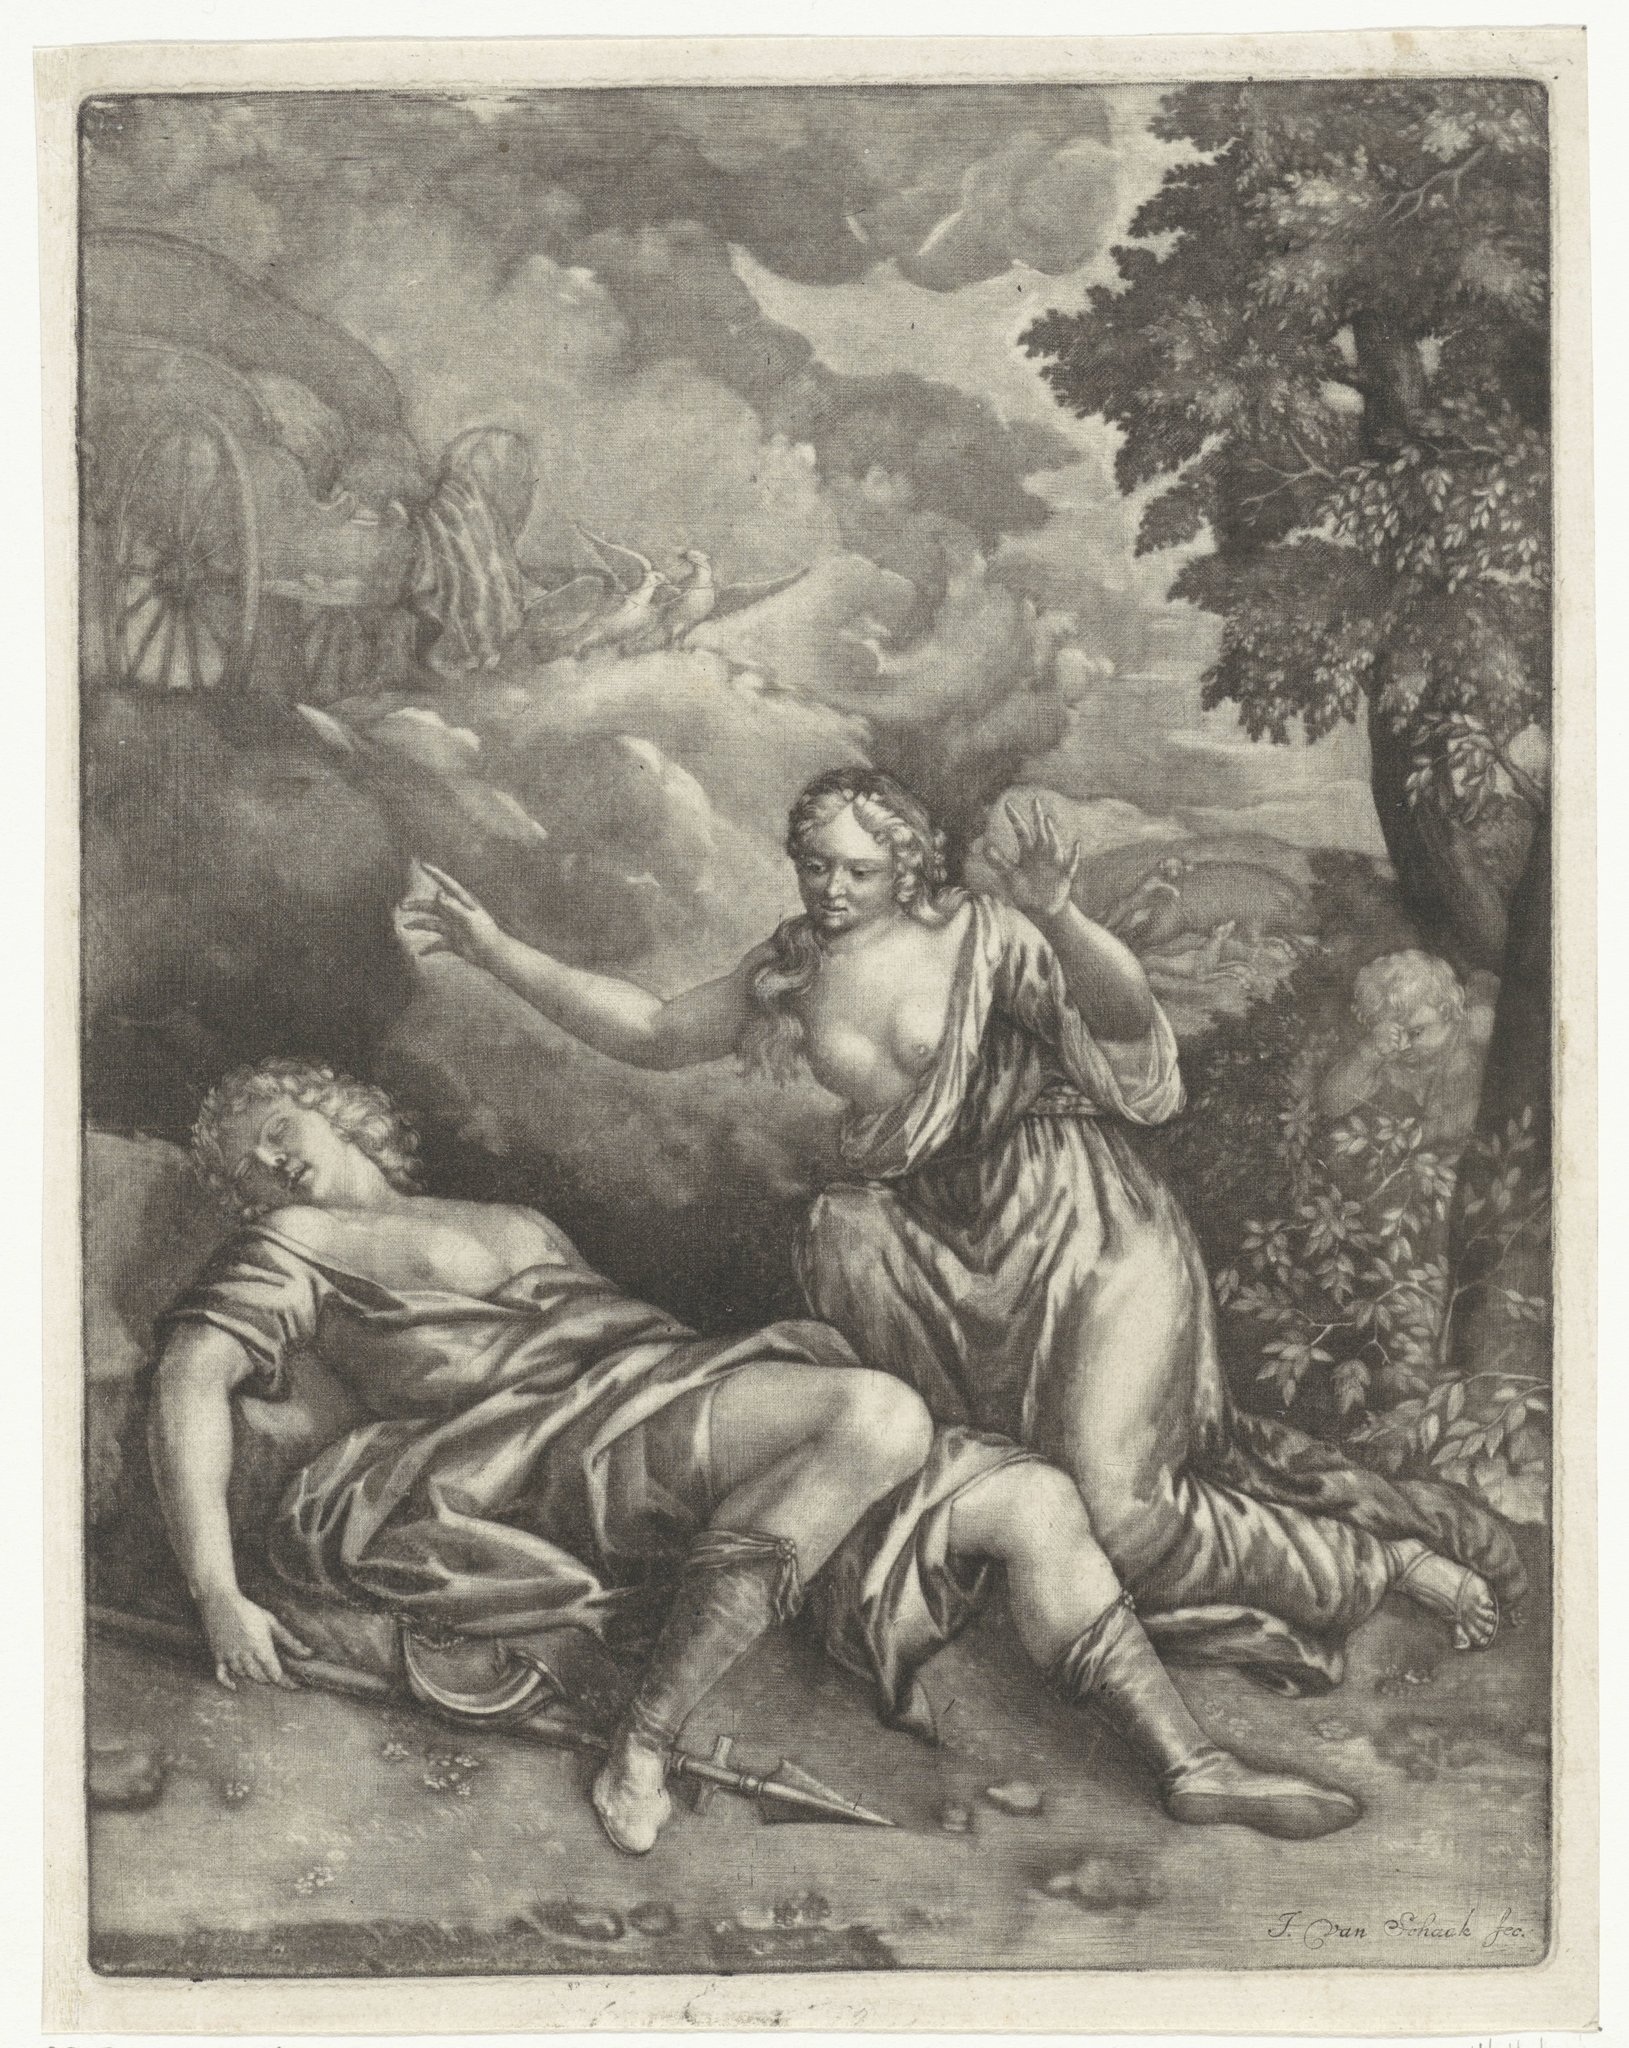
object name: print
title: Venus and Adonis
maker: jeremias van schaak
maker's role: print maker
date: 1690-1727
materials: paper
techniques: mezzotint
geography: northern netherlands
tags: venus and adonis as lovers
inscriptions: collector's mark: Lugt 2166, collector's mark: Lugt 2760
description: Venus knielt bij Adonis neer. In de wolken staat haar lege wagen te wachten.